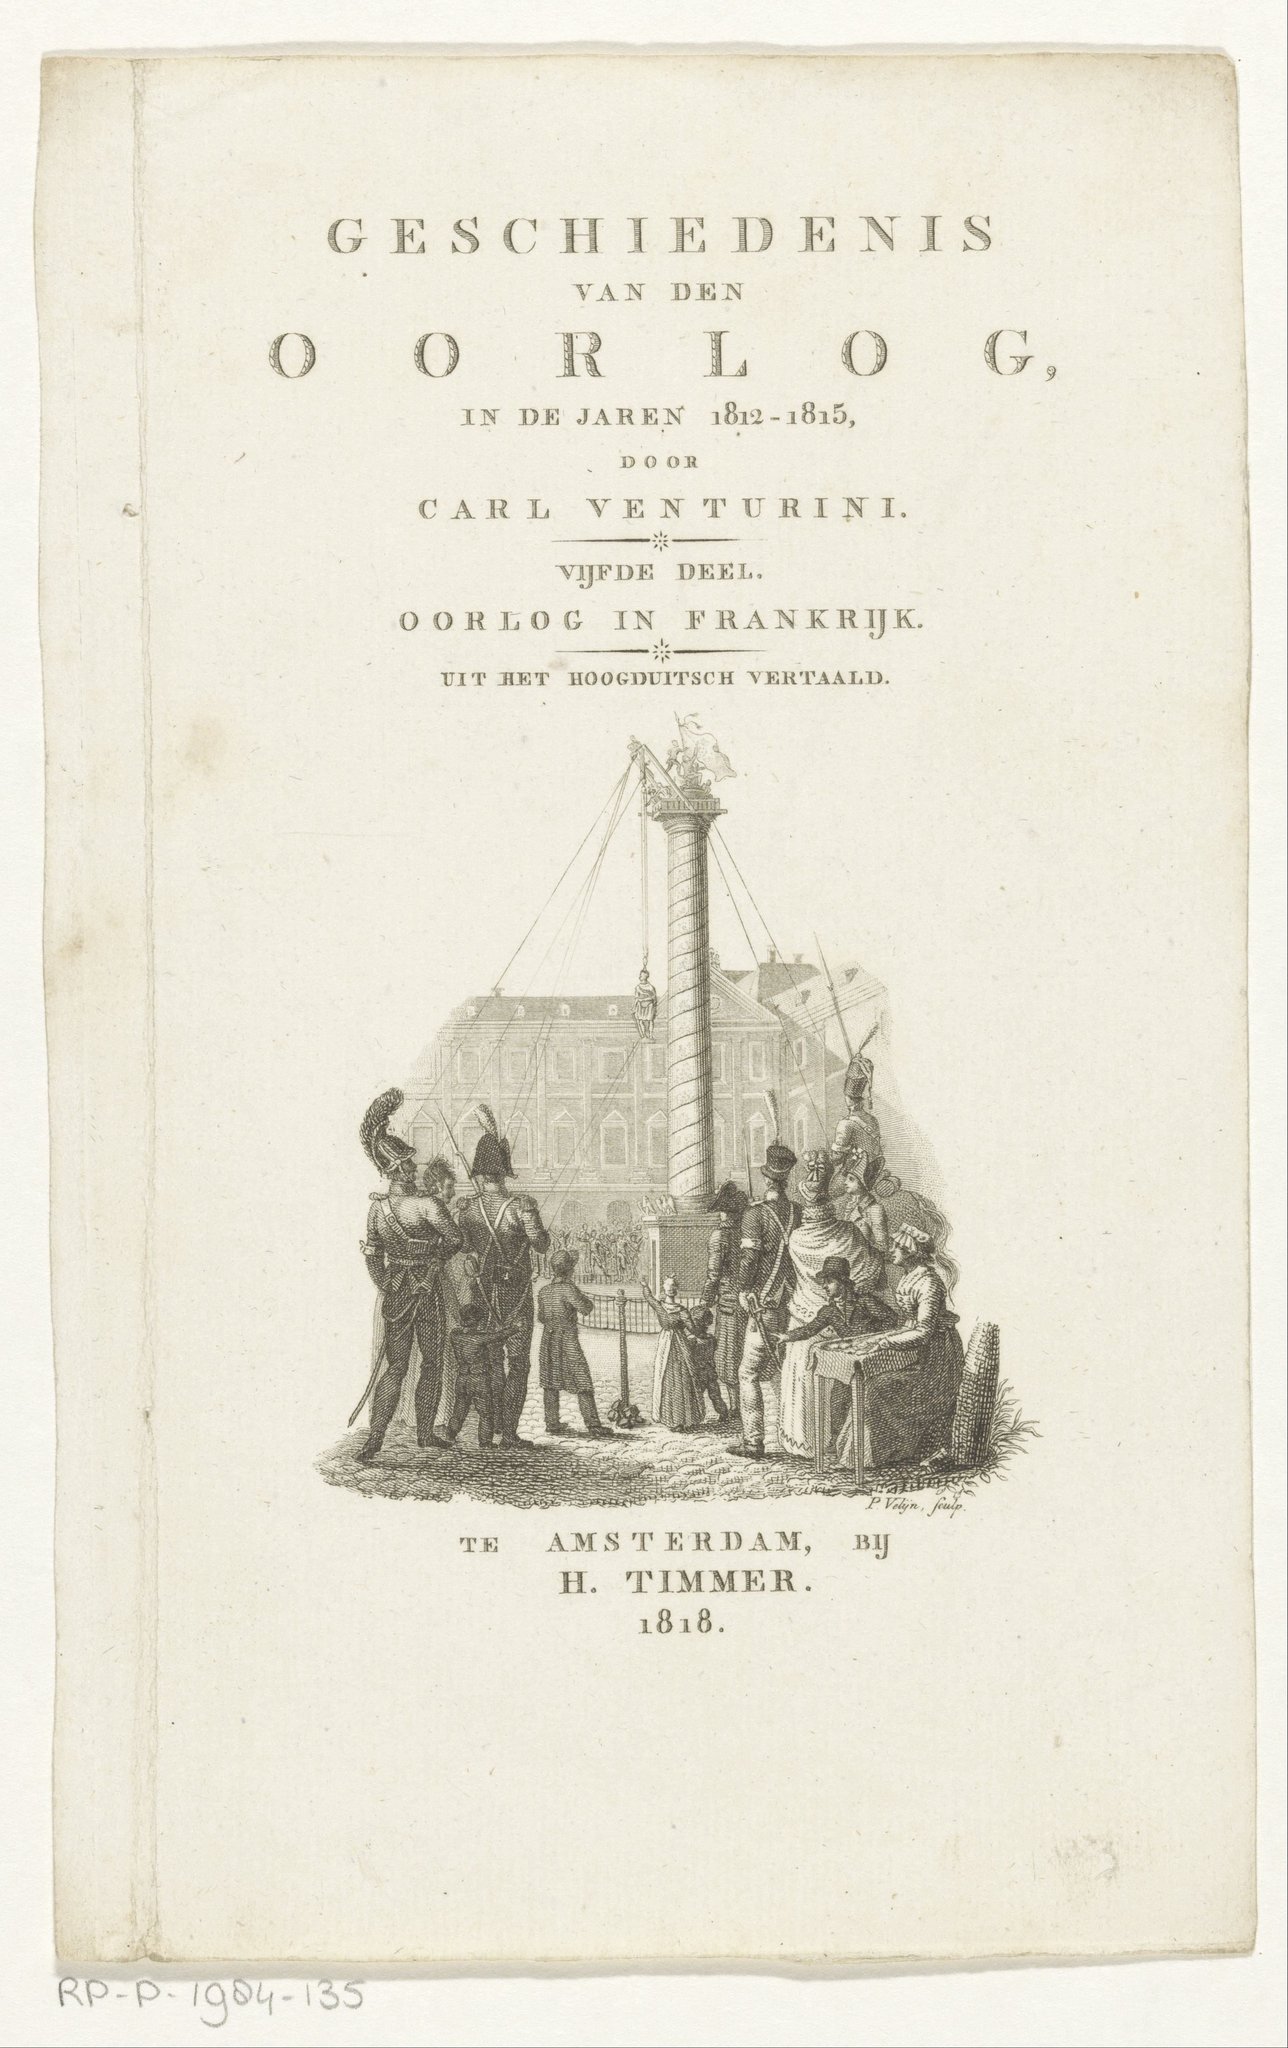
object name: print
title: Vlag op Colonne Vendôme te Parijs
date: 1818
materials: paper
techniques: engraving, etching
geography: amsterdam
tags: column, pillar ~ architecture, flag, colours (as symbol of the state, etc.)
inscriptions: collector's mark: Lugt 2228, collector's mark: Lugt 2760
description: In 1814, tijdens de bezetting van Parijs door geallieerde troepen, werd het beeld van Napoleon op de Colonne Vendôme verwijderd en vervangen door een witte vlag met fleur-de-lis. Een groep omstanders kijkt hoe het beeld omlaag wordt gebracht en de vlag wordt geplaatst.